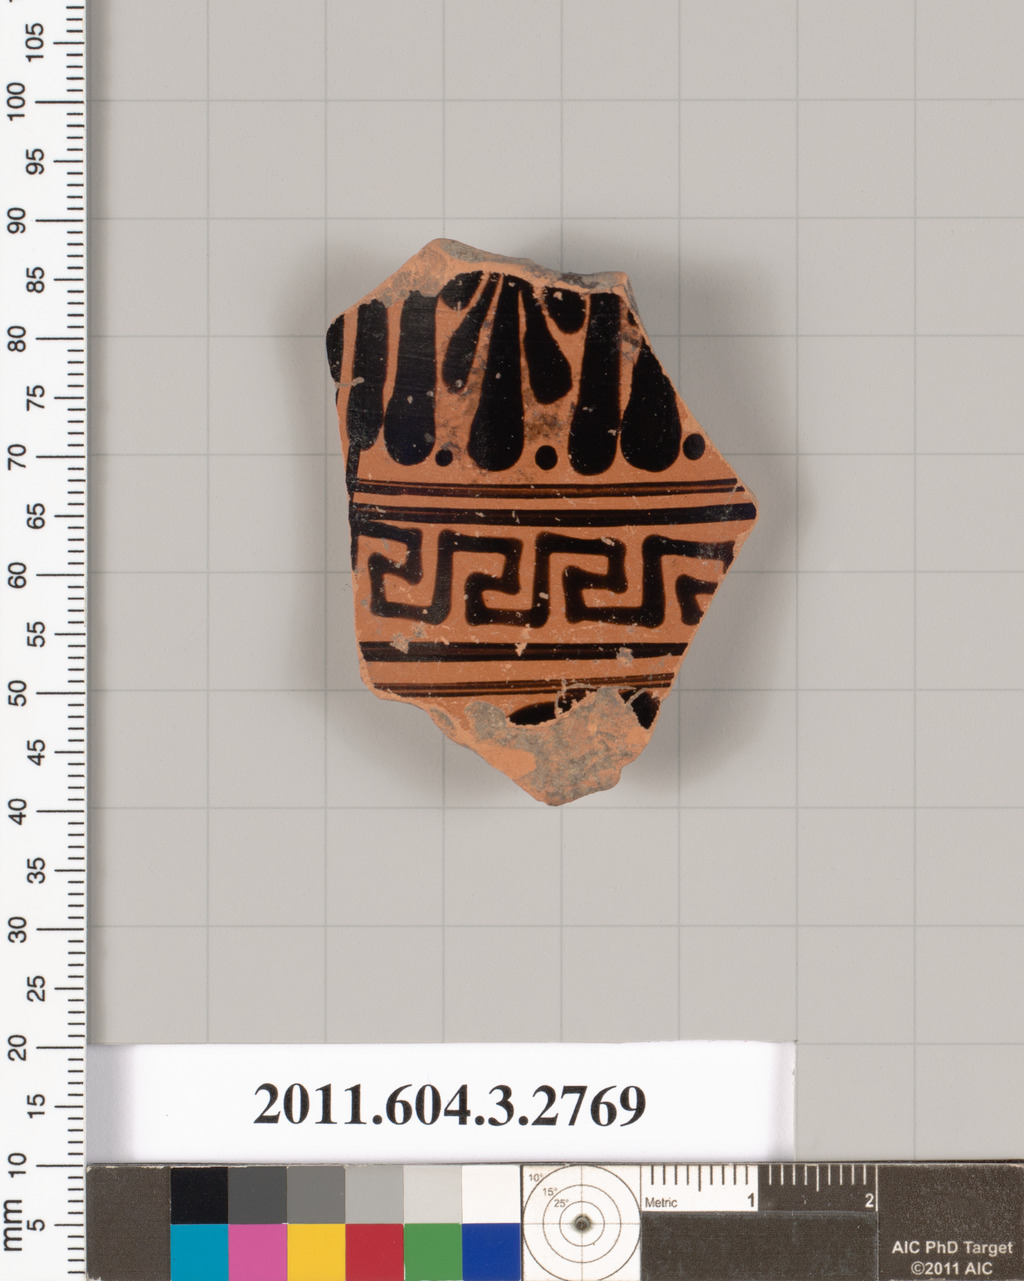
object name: olpe fragment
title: Terracotta fragment of an olpe (jug)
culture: greek, attic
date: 525-501 BCE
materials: terracotta